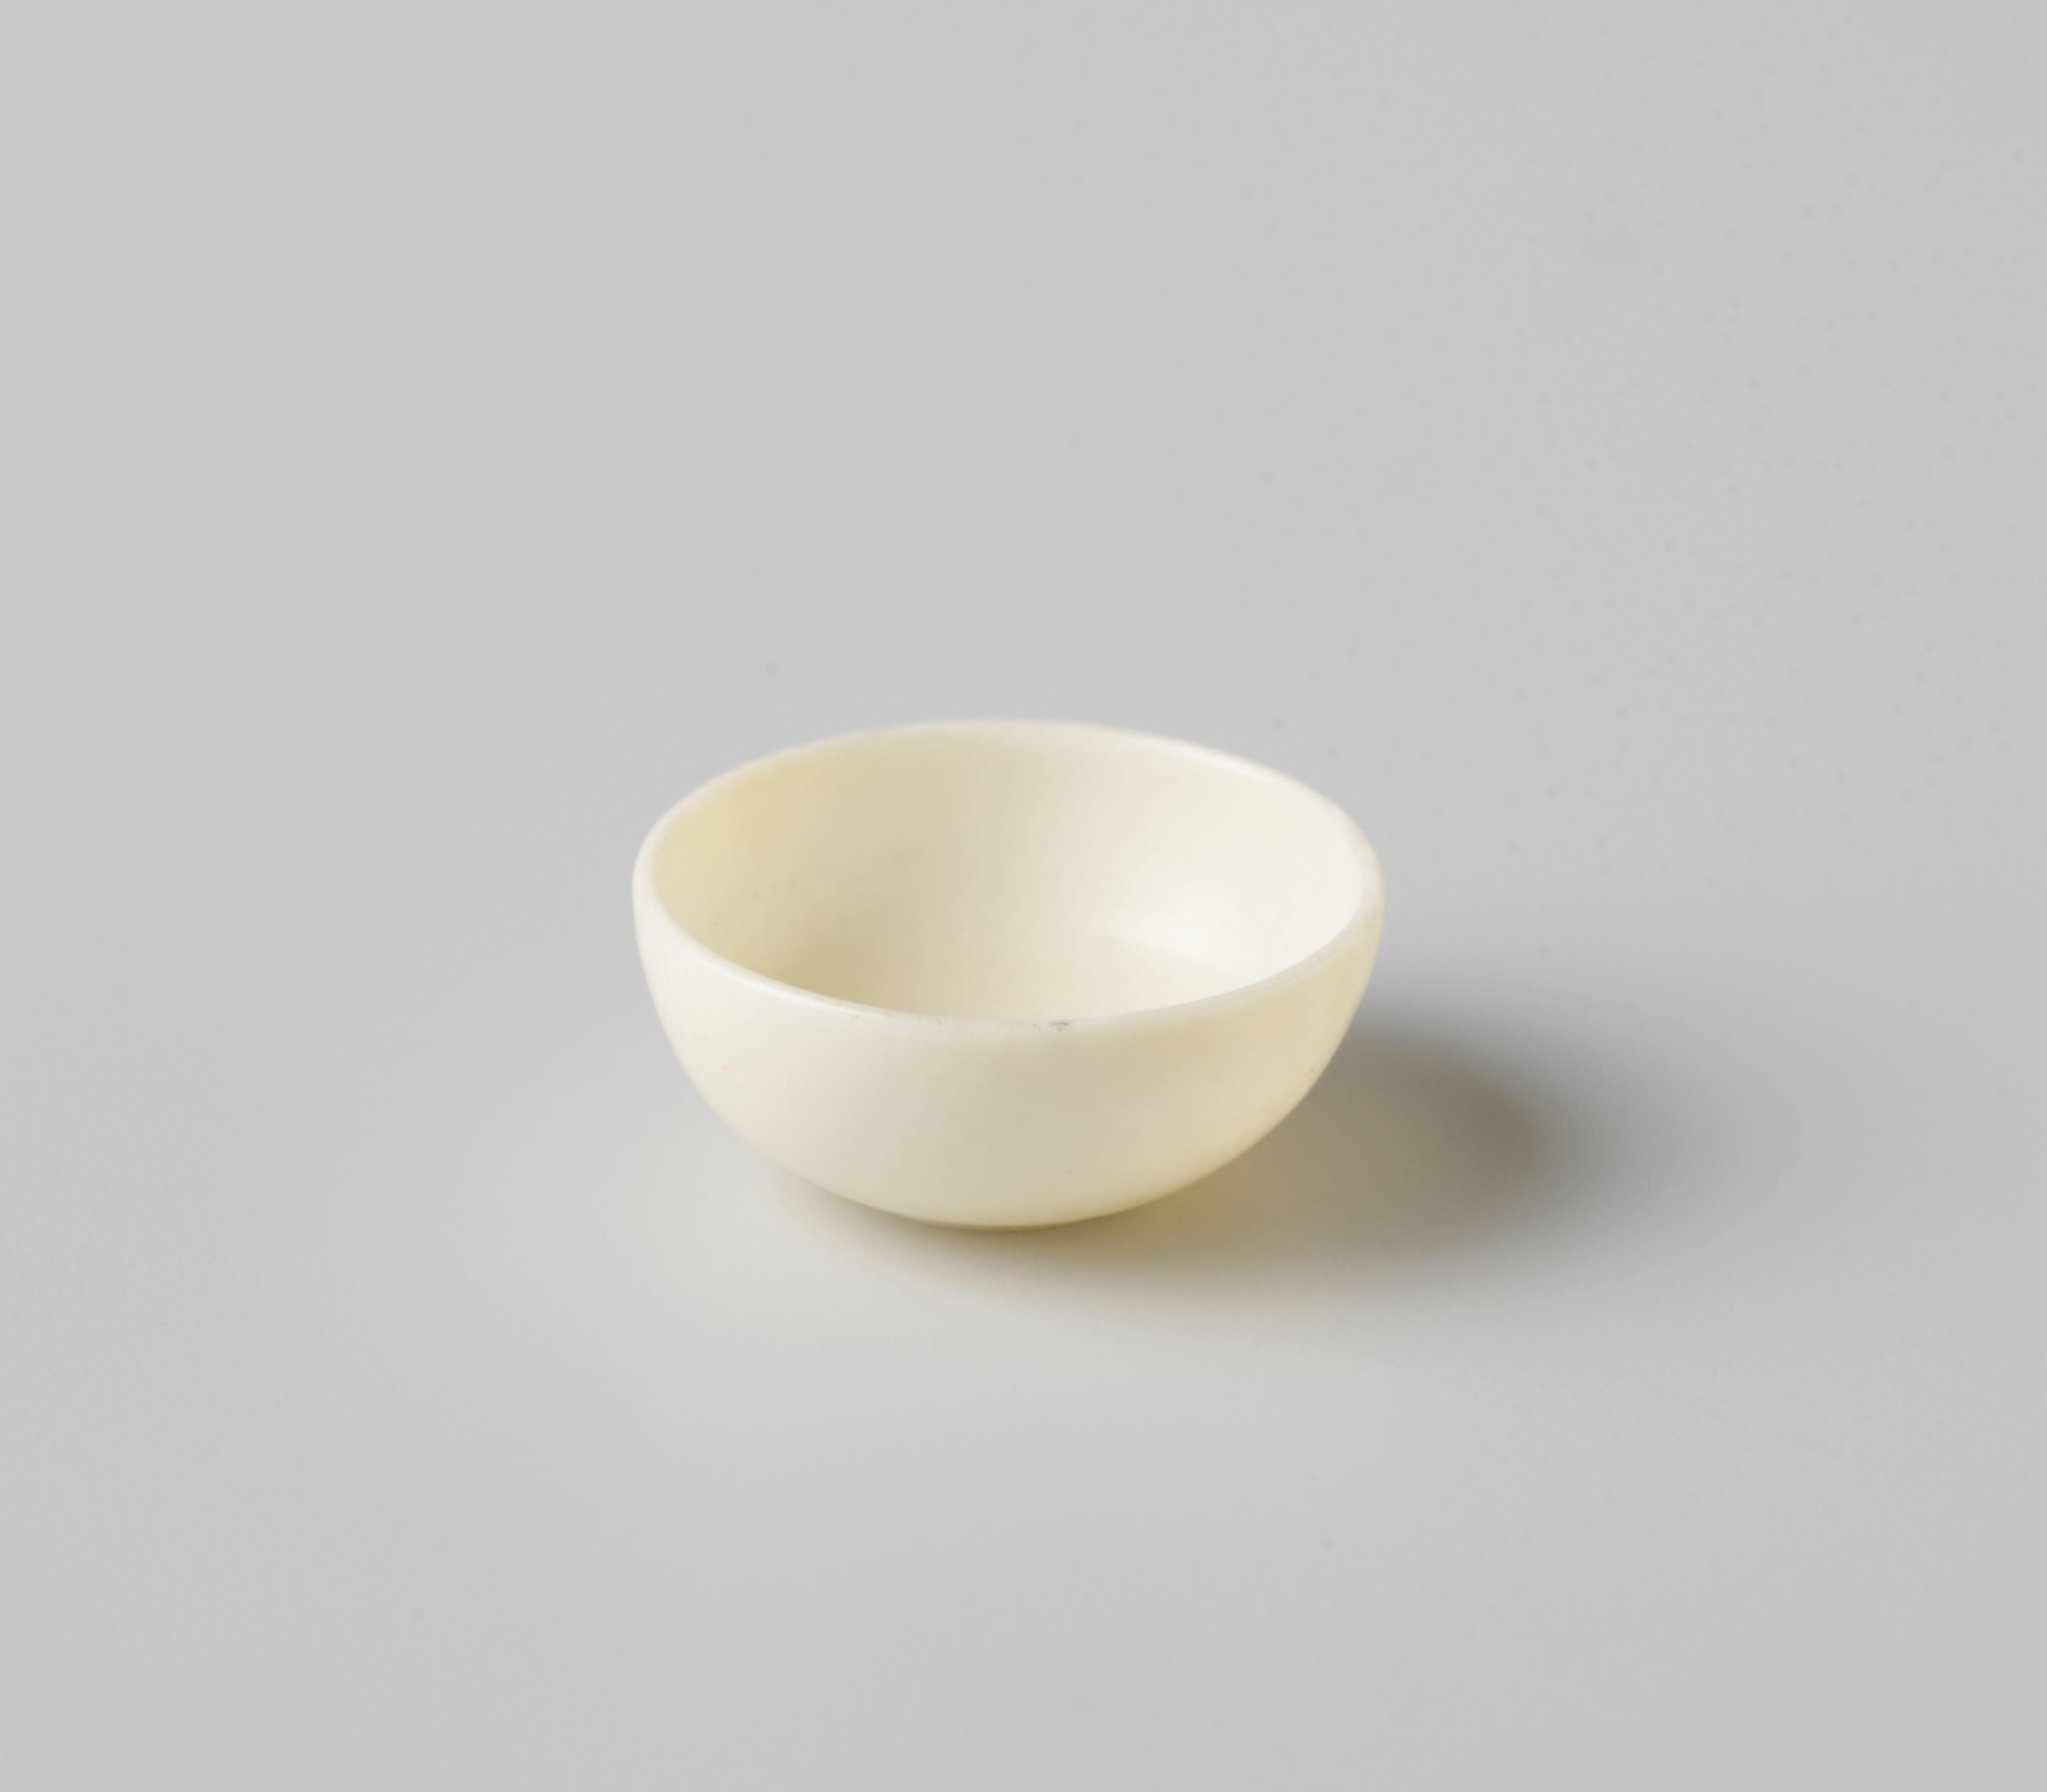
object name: slop bowl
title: Spoelkom van ivoor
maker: Anonymous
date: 1700-1799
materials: ivory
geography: germany